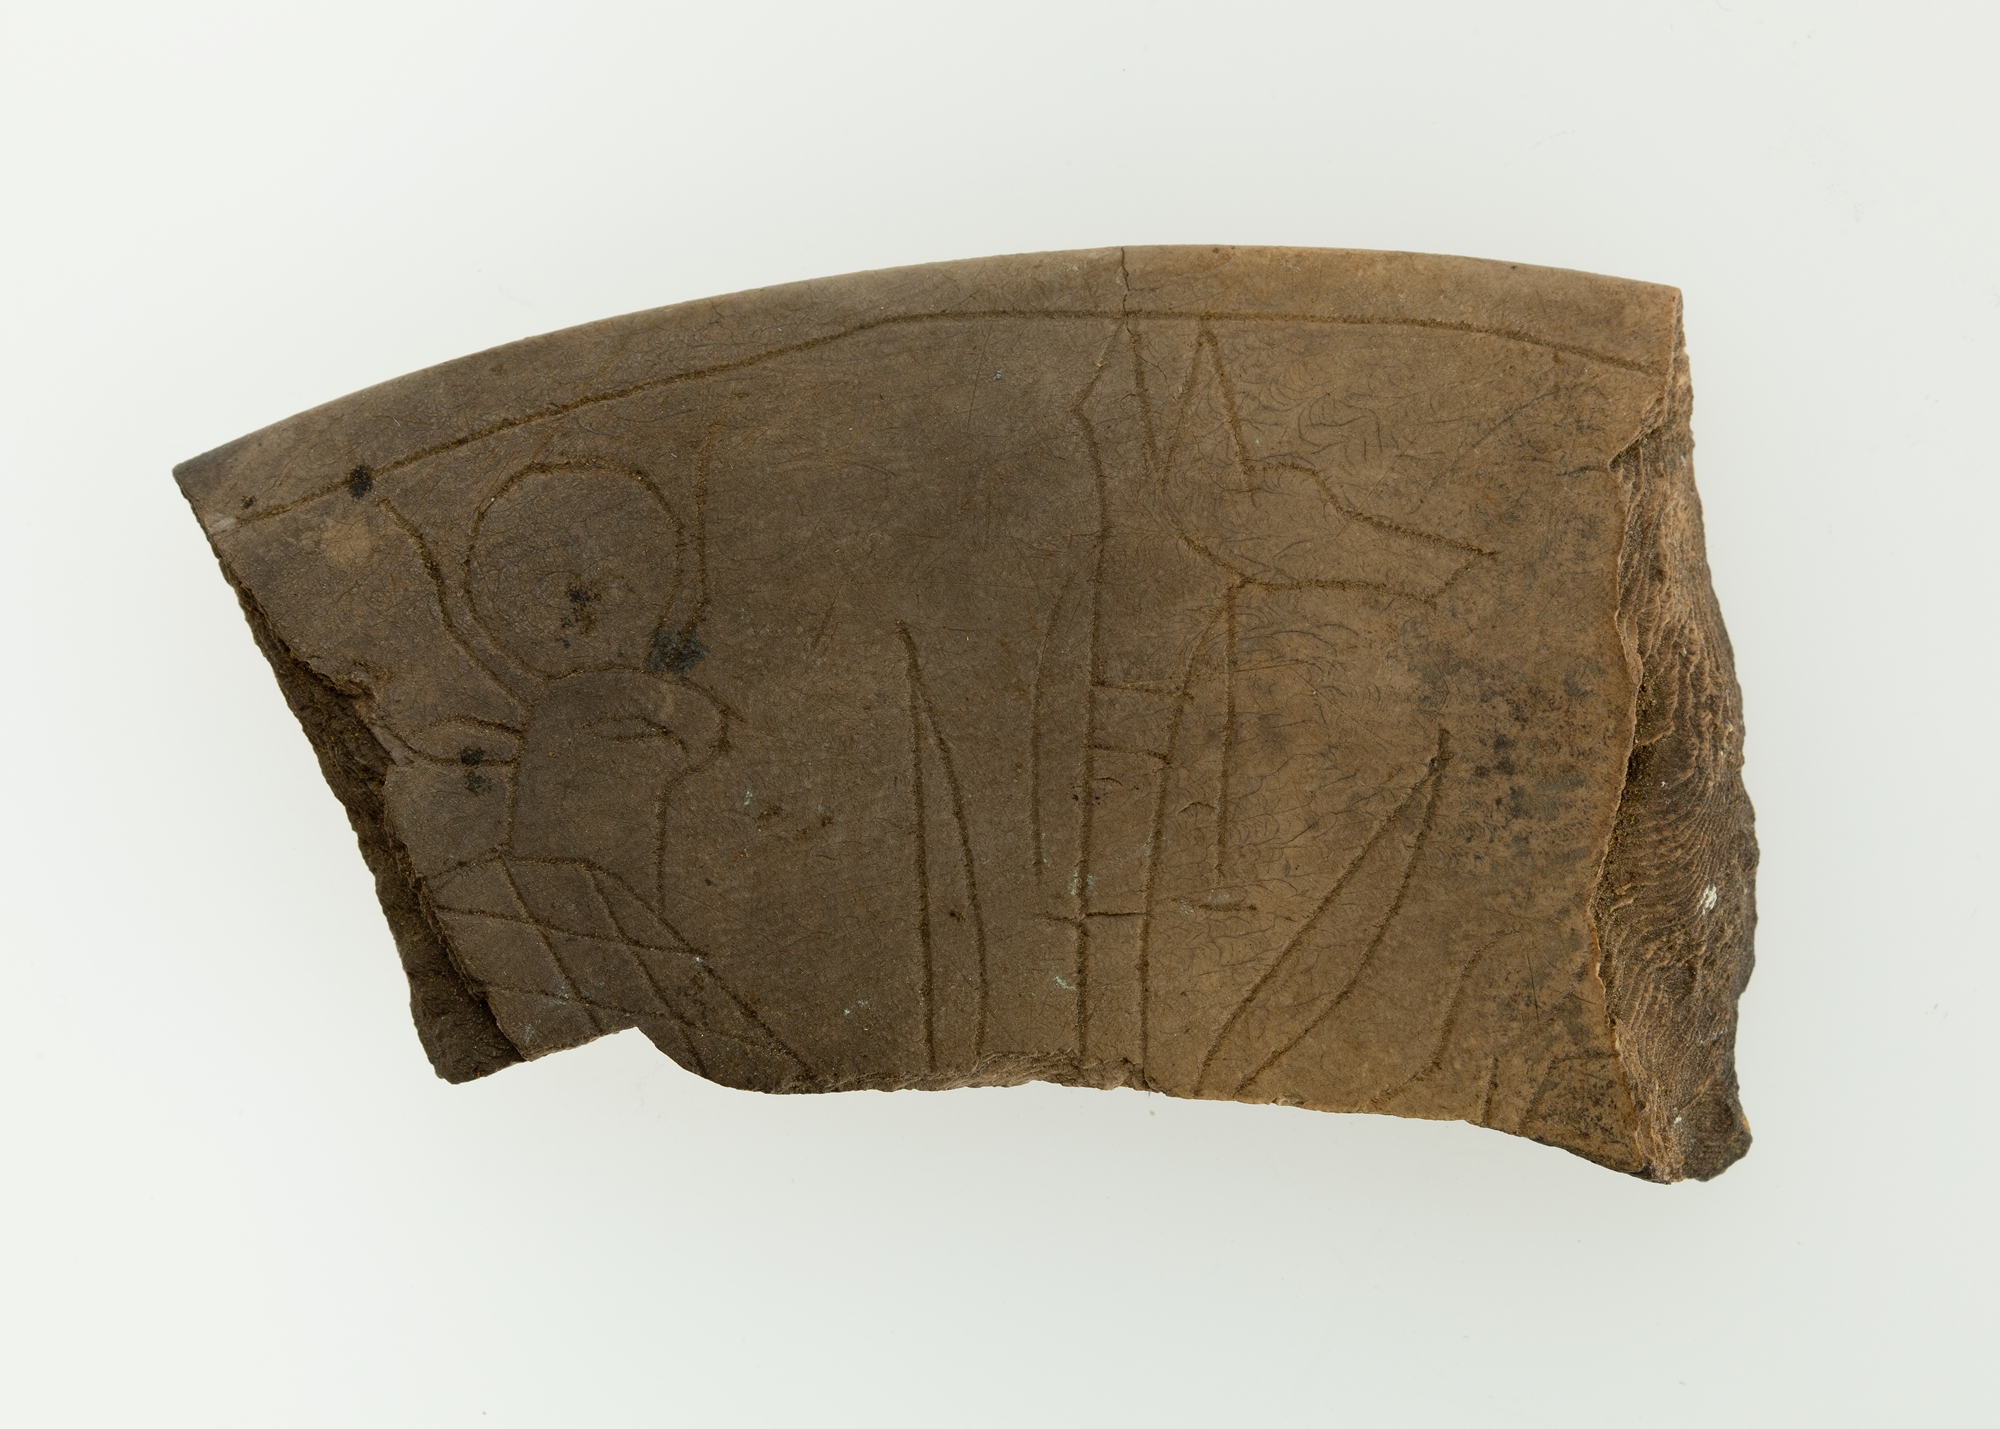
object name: magic knife fragment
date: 1850-1775 BCE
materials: ivory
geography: egypt